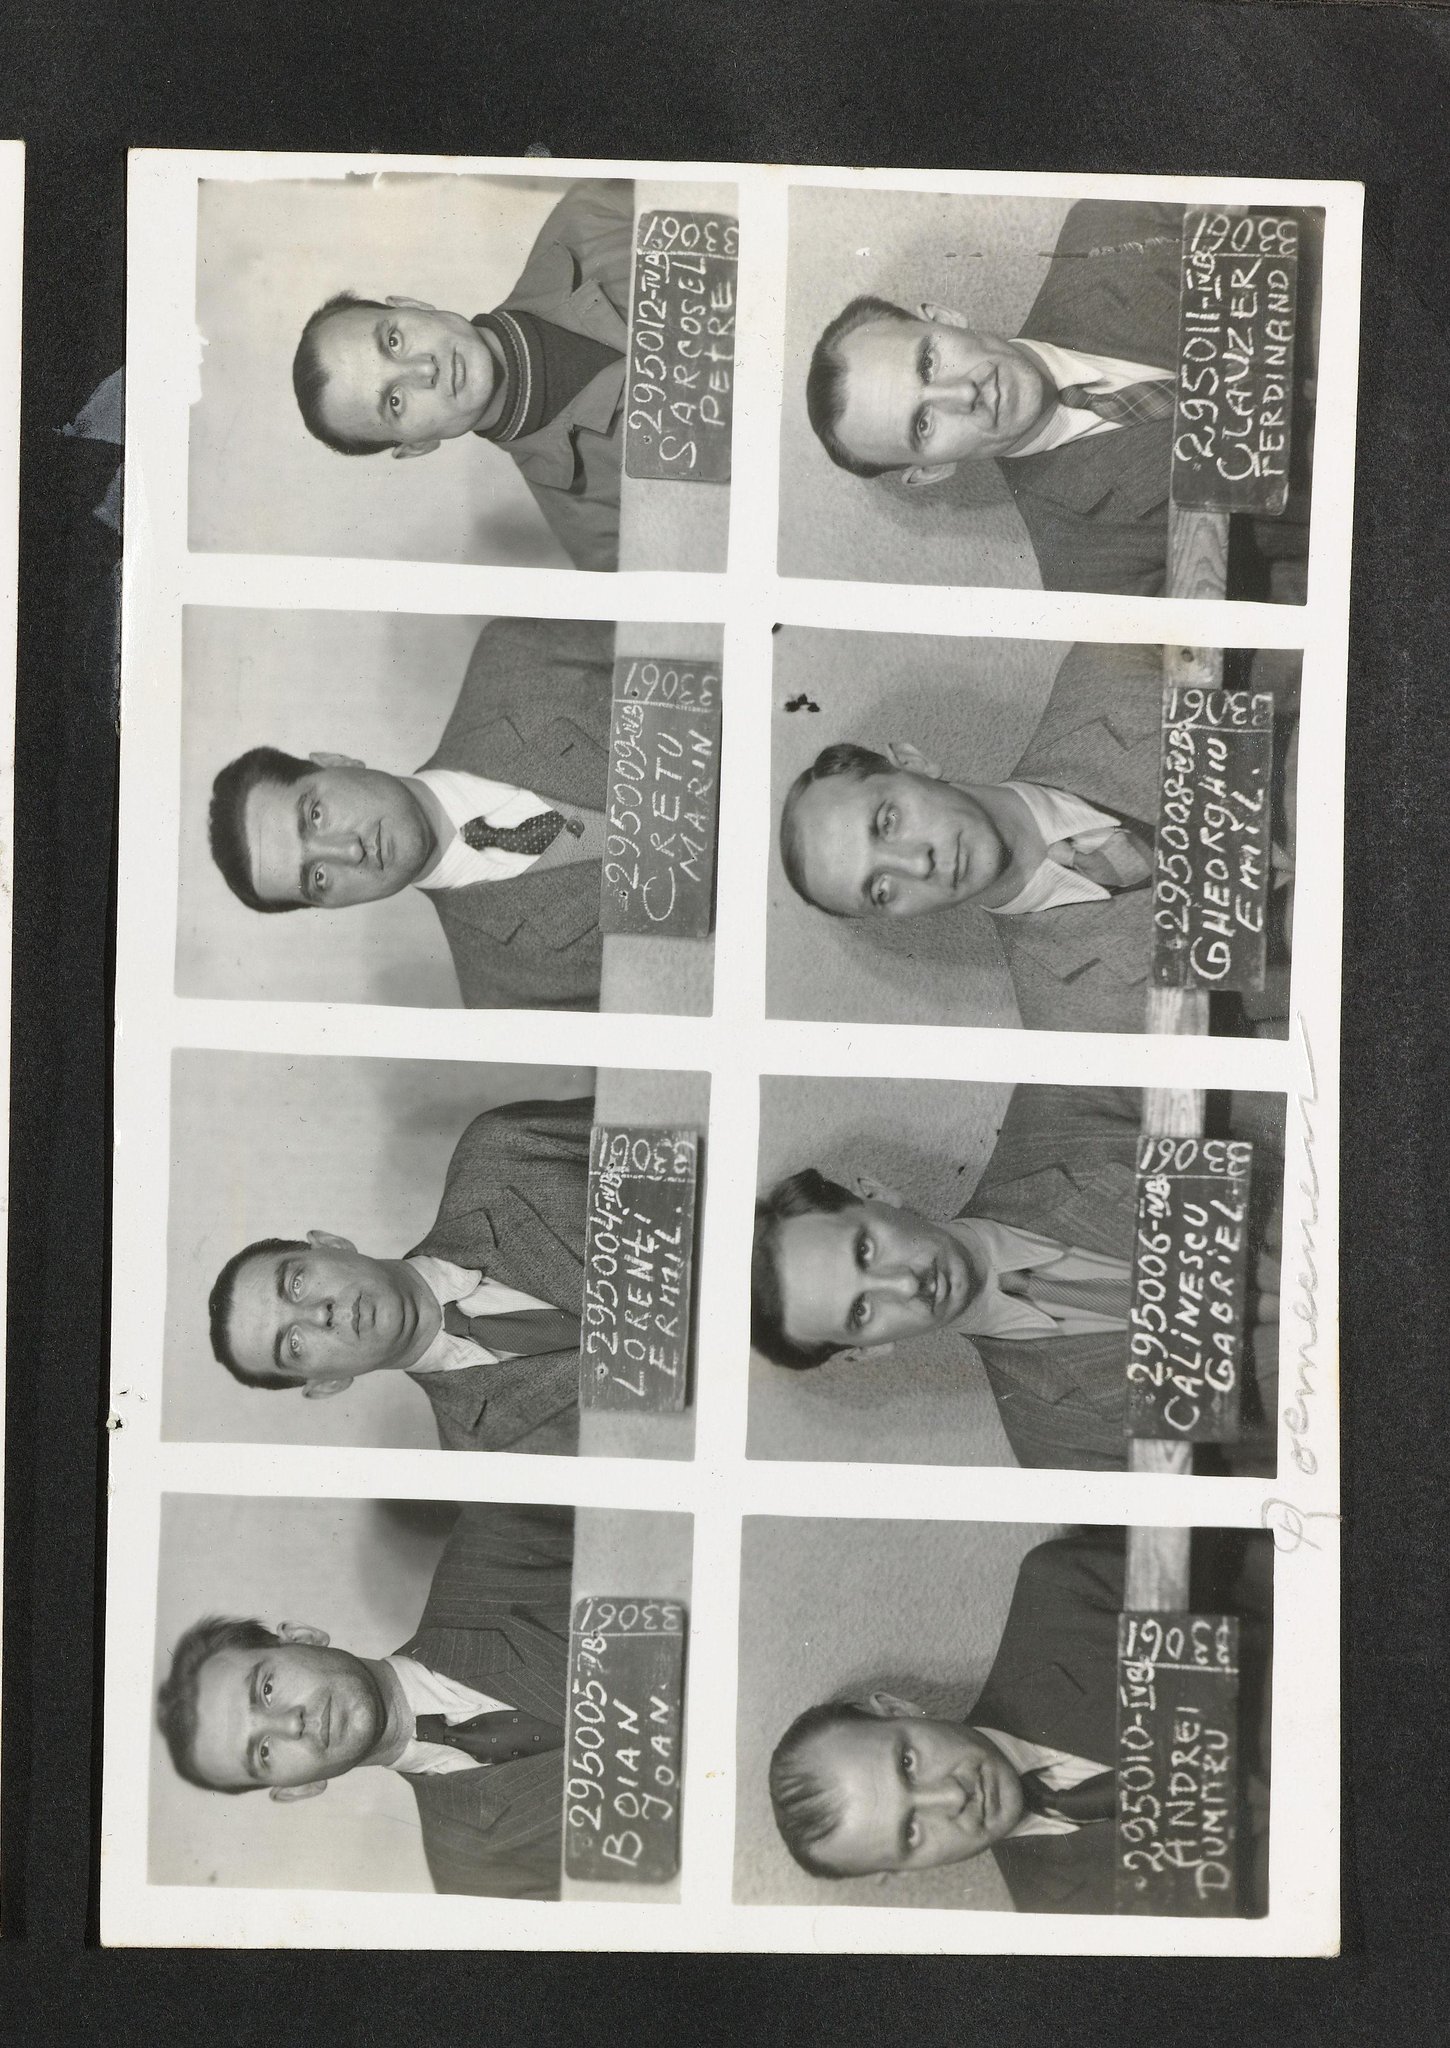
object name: photograph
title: Krijgsgevangenen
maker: dick w.b. van maarseveen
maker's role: fotograaf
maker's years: 1905-1990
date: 1943-1945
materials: cardboard, photographic support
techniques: gelatin silver print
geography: muhlberg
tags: the hague, dick w.b. van maarseveen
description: Albumblad met twee foto's: overzicht van de grote straat in het kamp en een groep krijgsgevangenen uit een kolonie en een blad met acht portretfoto's van Oost-Europese krijgsgevangenen. Onderdeel van een fotoalbum met foto's door Dick van Maarseveen van het krijgsgevangenenkamp Stalag IV B in Mühlberg in de periode 1943-1945.